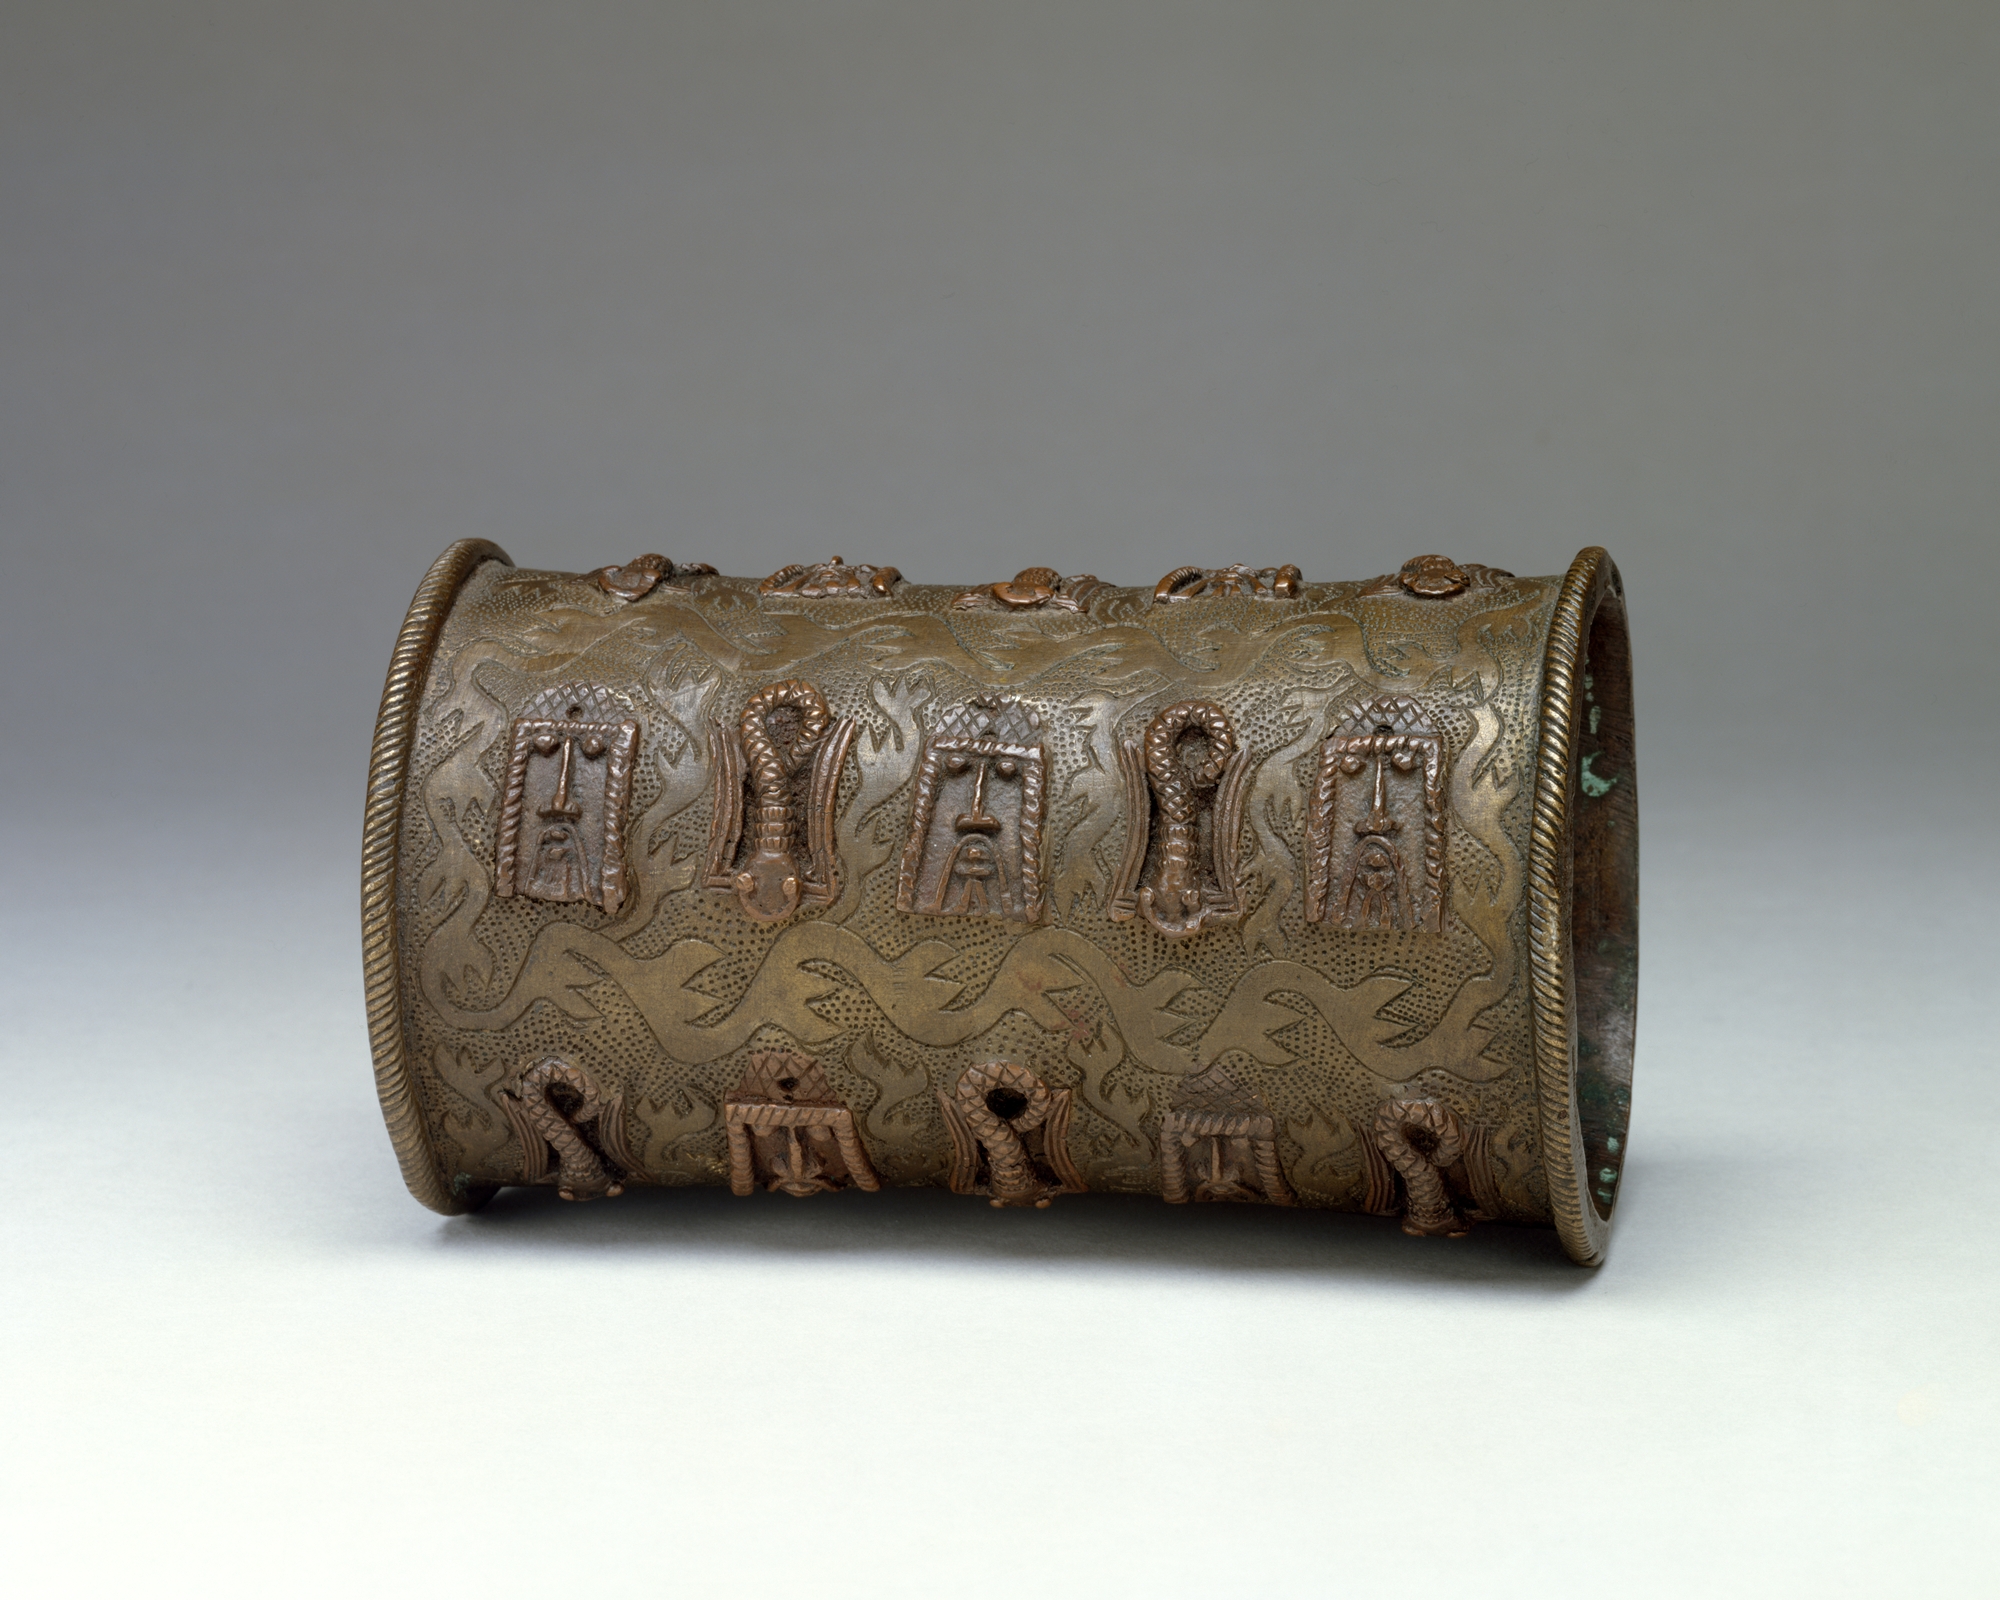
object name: bracelet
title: Bracelet: Portuguese Heads and Mudfish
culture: edo period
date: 1701-1900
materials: brass, copper alloy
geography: nigeria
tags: heads,fish